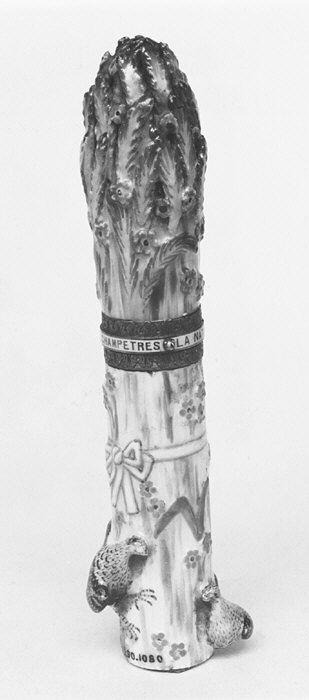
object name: needle case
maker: meissen manufactory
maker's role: manufactory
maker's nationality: german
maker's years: 1710-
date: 1701-1800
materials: gold, porcelain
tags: birds